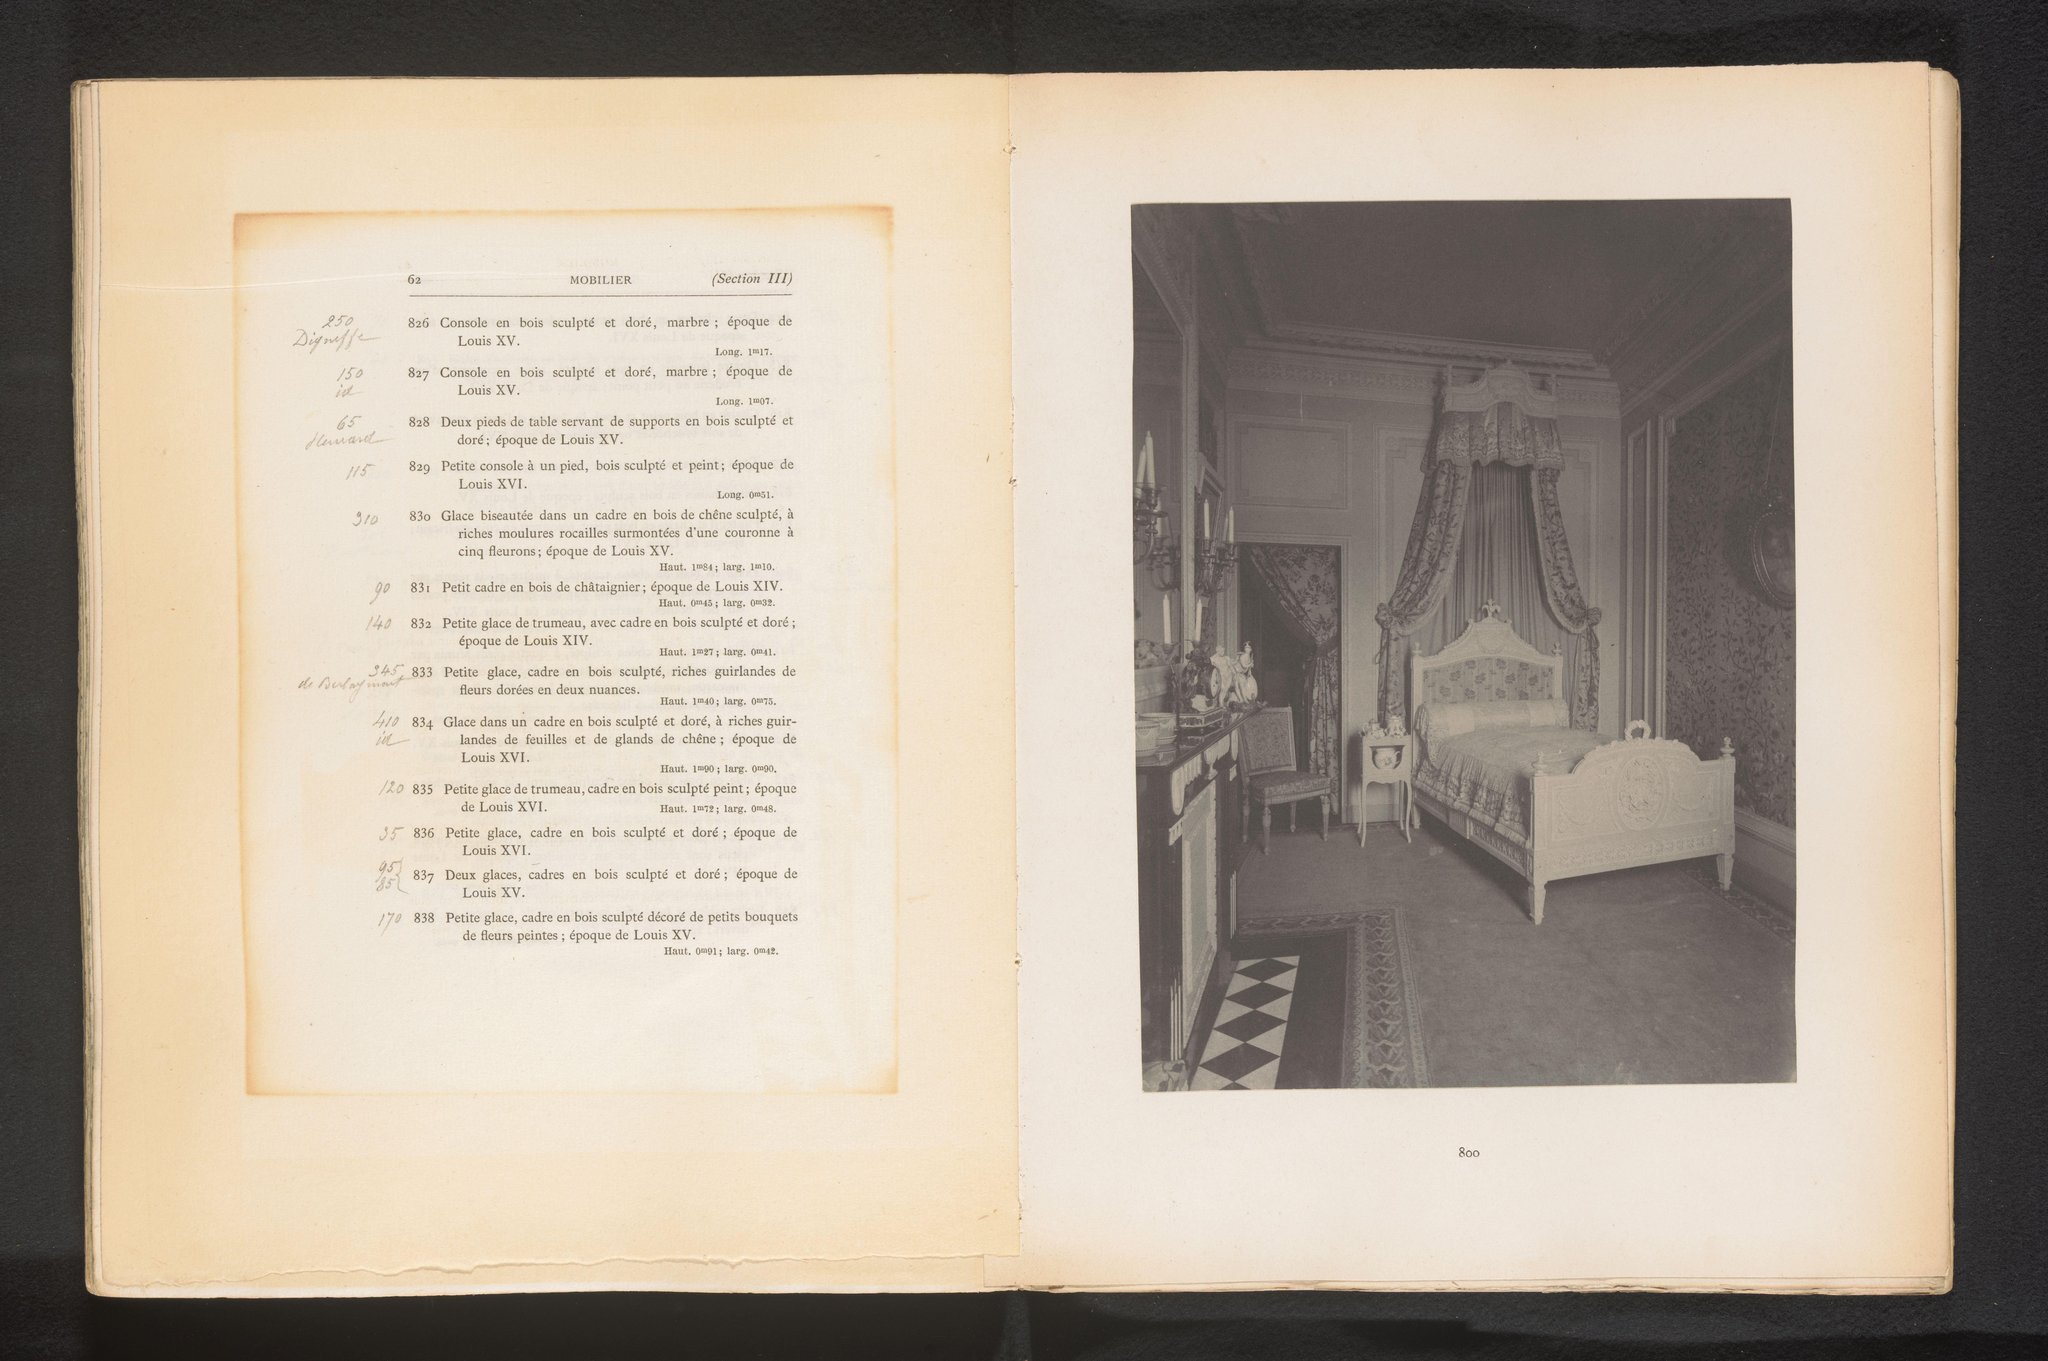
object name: photograph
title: Kamer in het huis van Antonin Terme met versierd bed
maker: Anonymous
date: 1880-1885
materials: photographic support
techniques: platinum process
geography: liège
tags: art collection, art gallery, bed